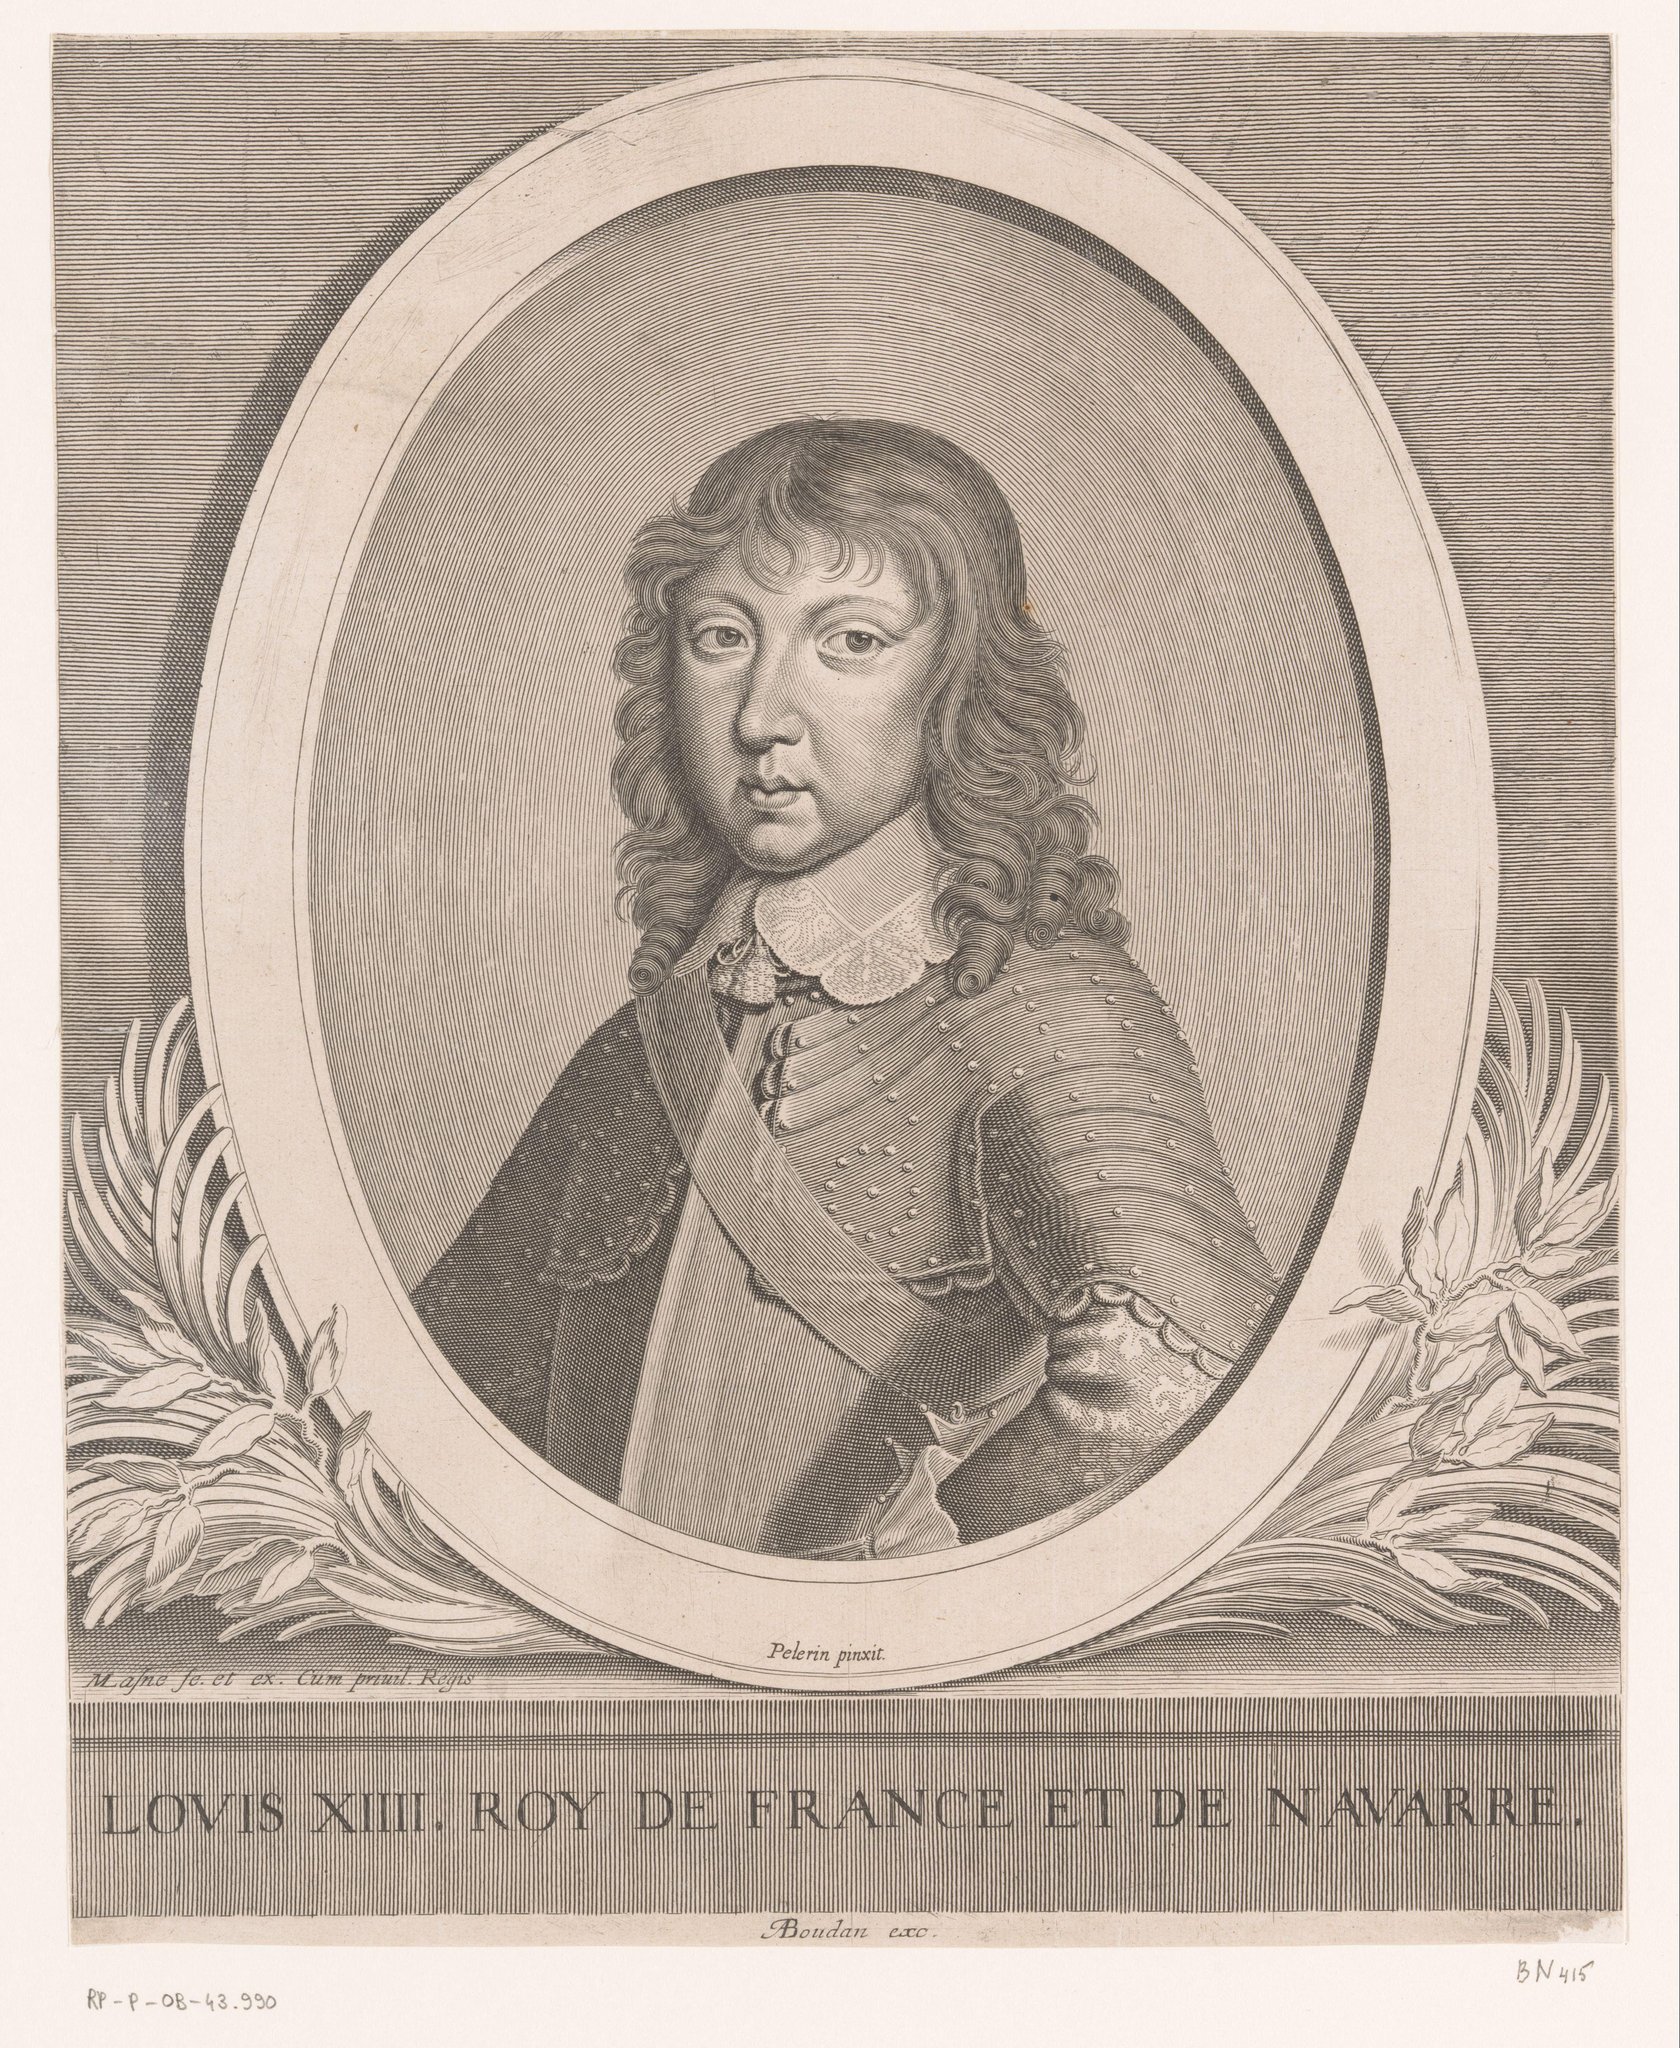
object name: print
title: Portret van Lodewijk XIV, koning van Frankrijk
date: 1610-1667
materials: paper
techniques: engraving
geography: france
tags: lodewijk xiv (koning van frankrijk), historical persons, king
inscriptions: collector's mark: Lugt 2228